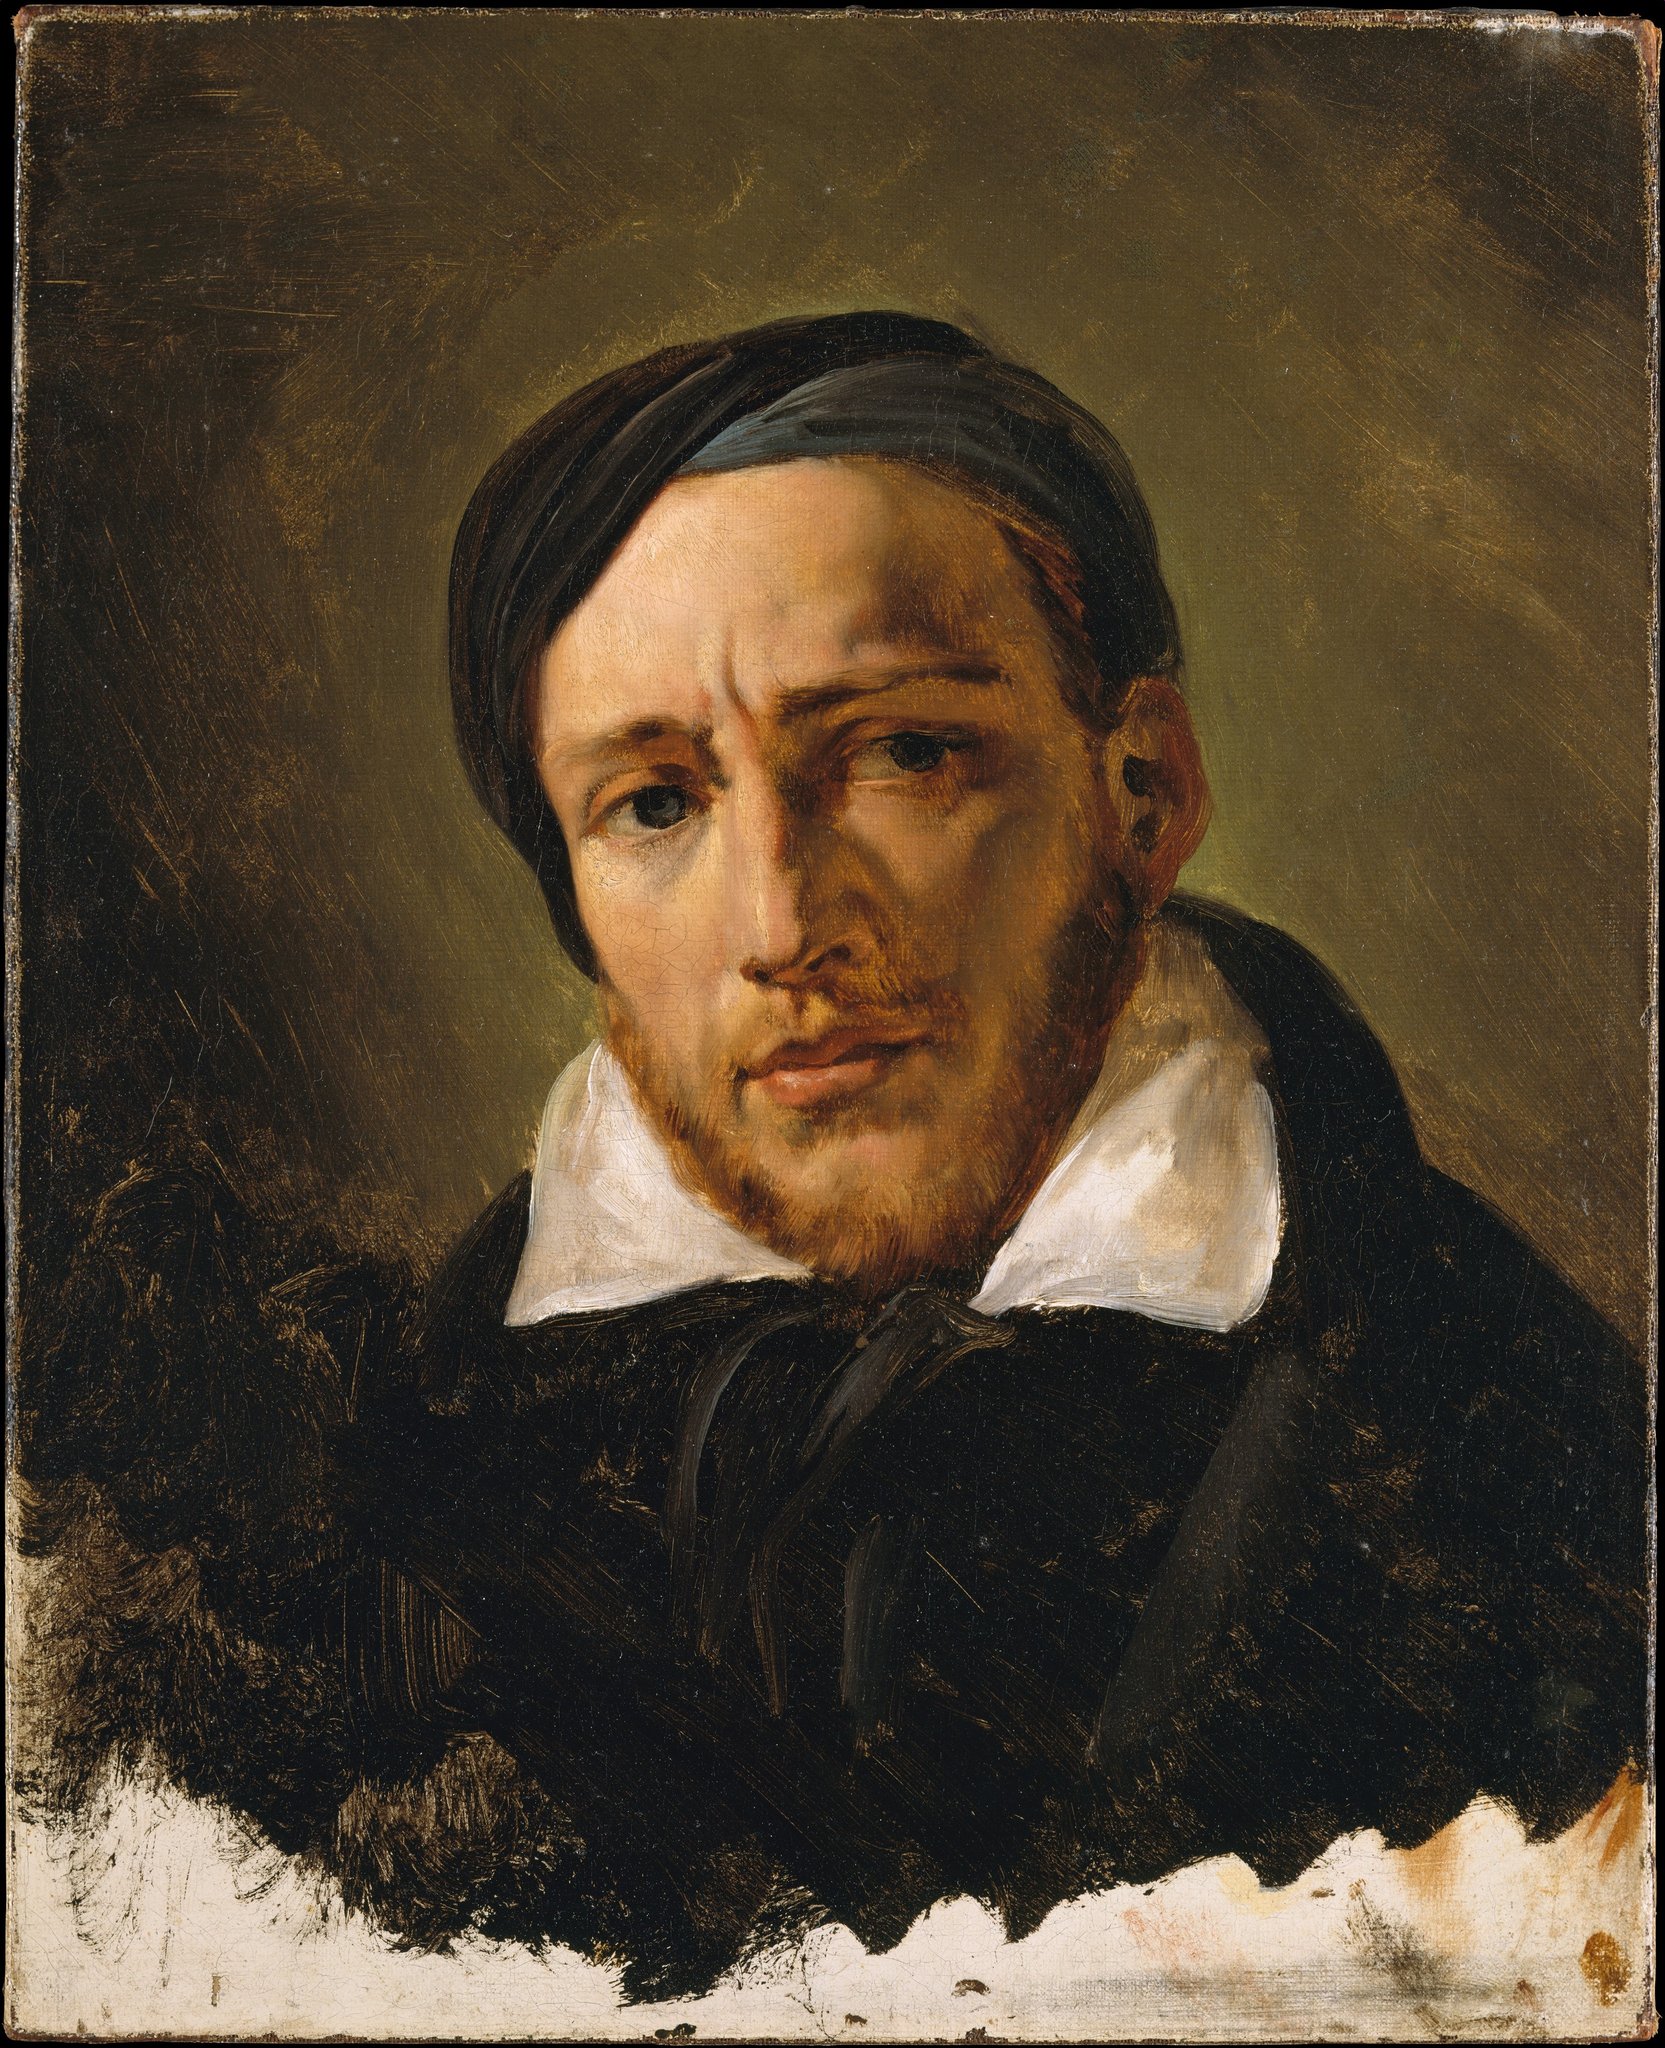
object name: painting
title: Jean-Louis-André-Théodore Gericault (1791–1824)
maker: horace vernet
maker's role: artist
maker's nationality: french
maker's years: 1789-1863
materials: canvas, oil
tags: men,portraits